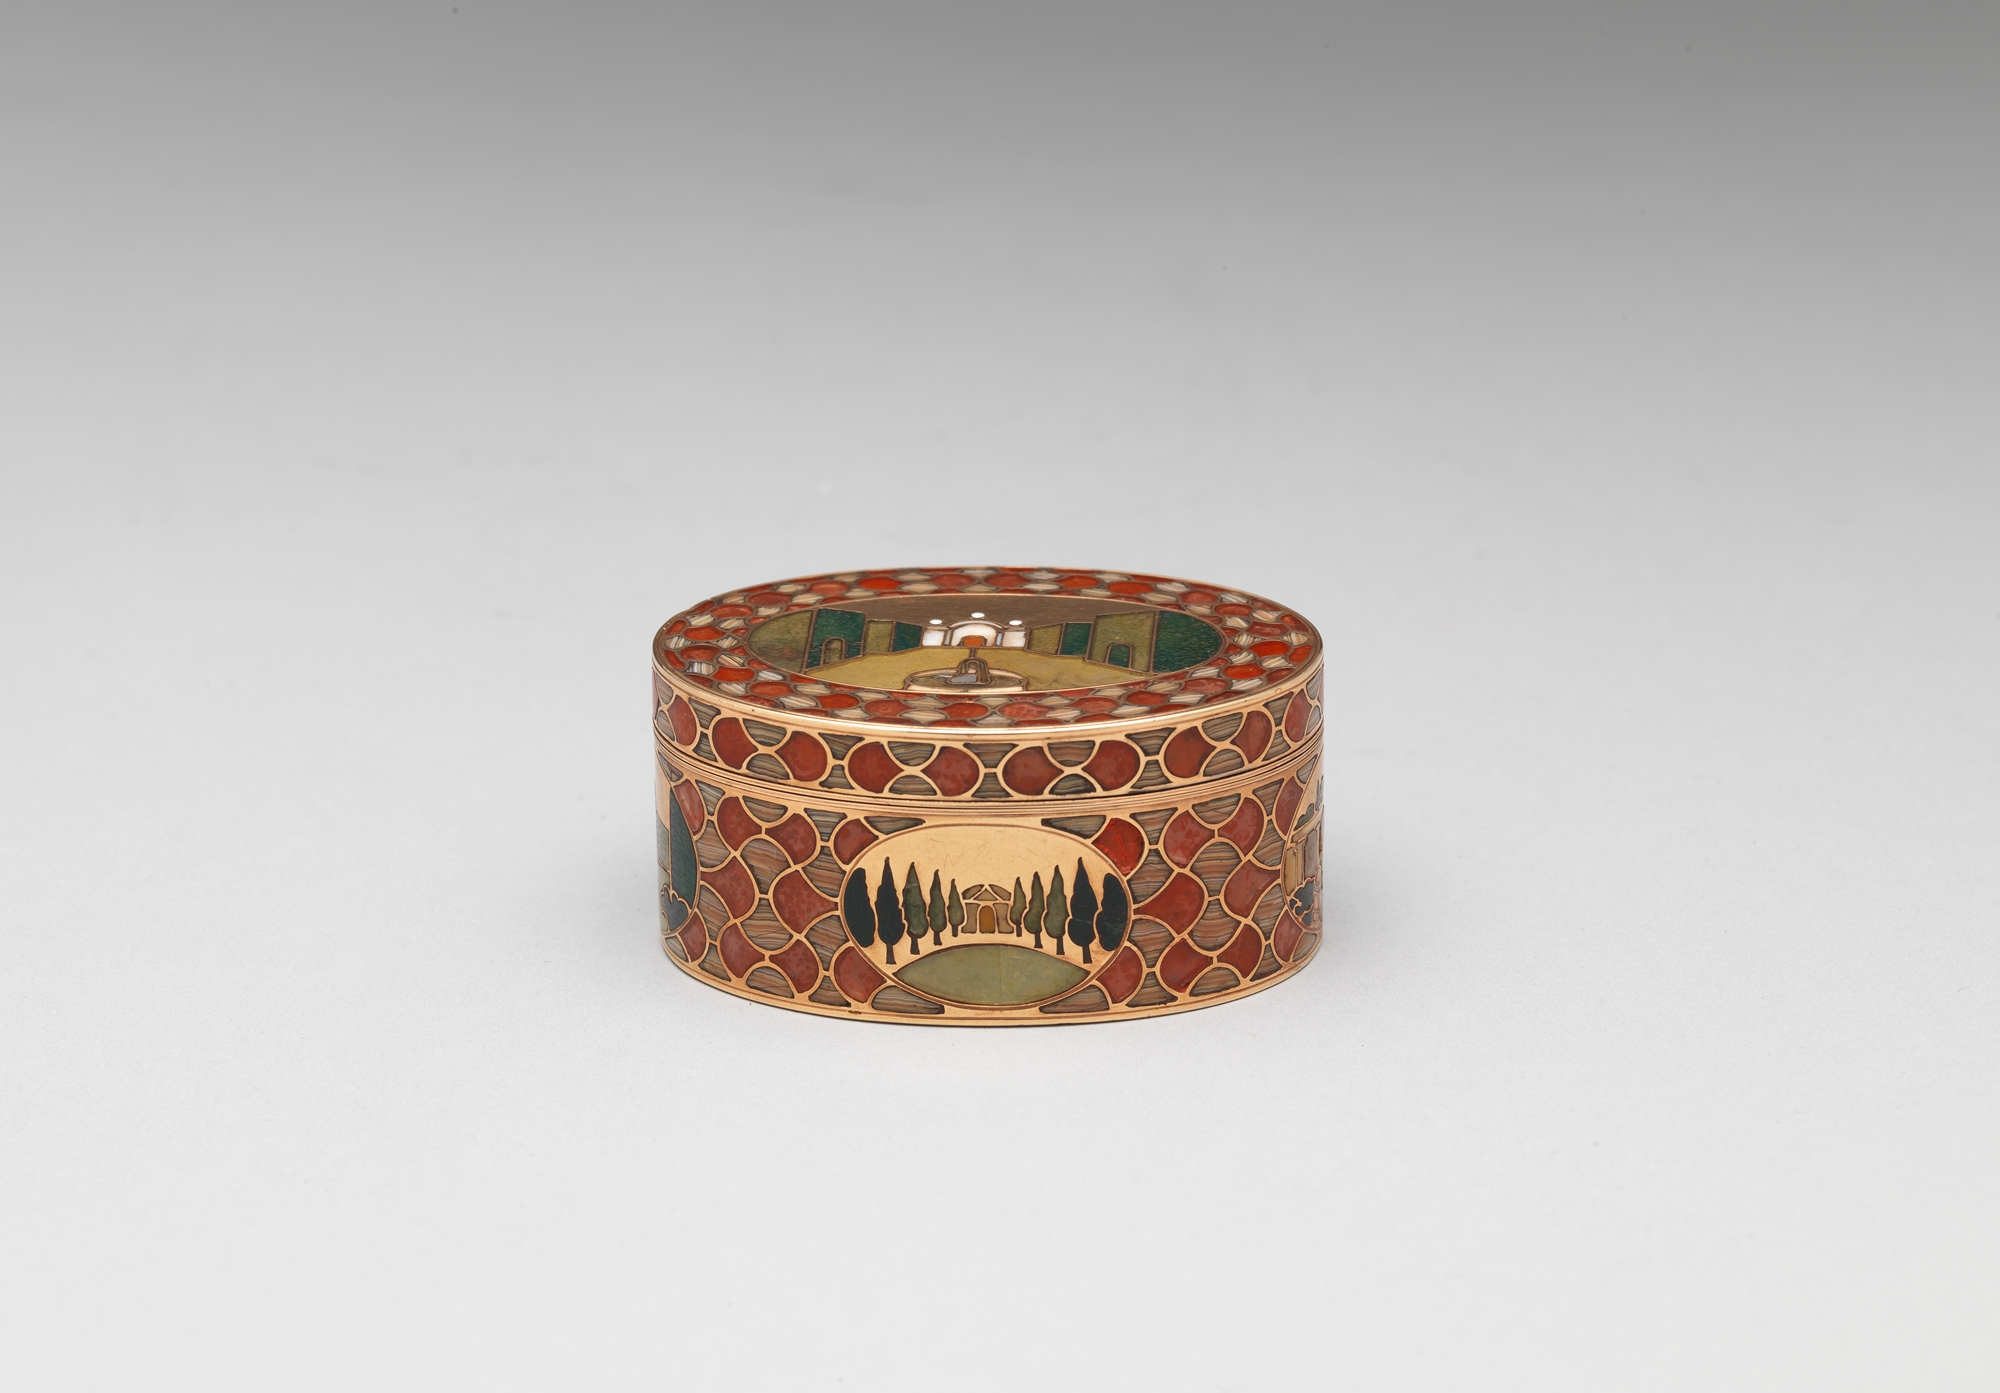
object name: snuffbox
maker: johann christian neuber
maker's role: maker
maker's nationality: german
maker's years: 1736-1808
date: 1767-1800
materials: stone, gemstone, gold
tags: houses,trees